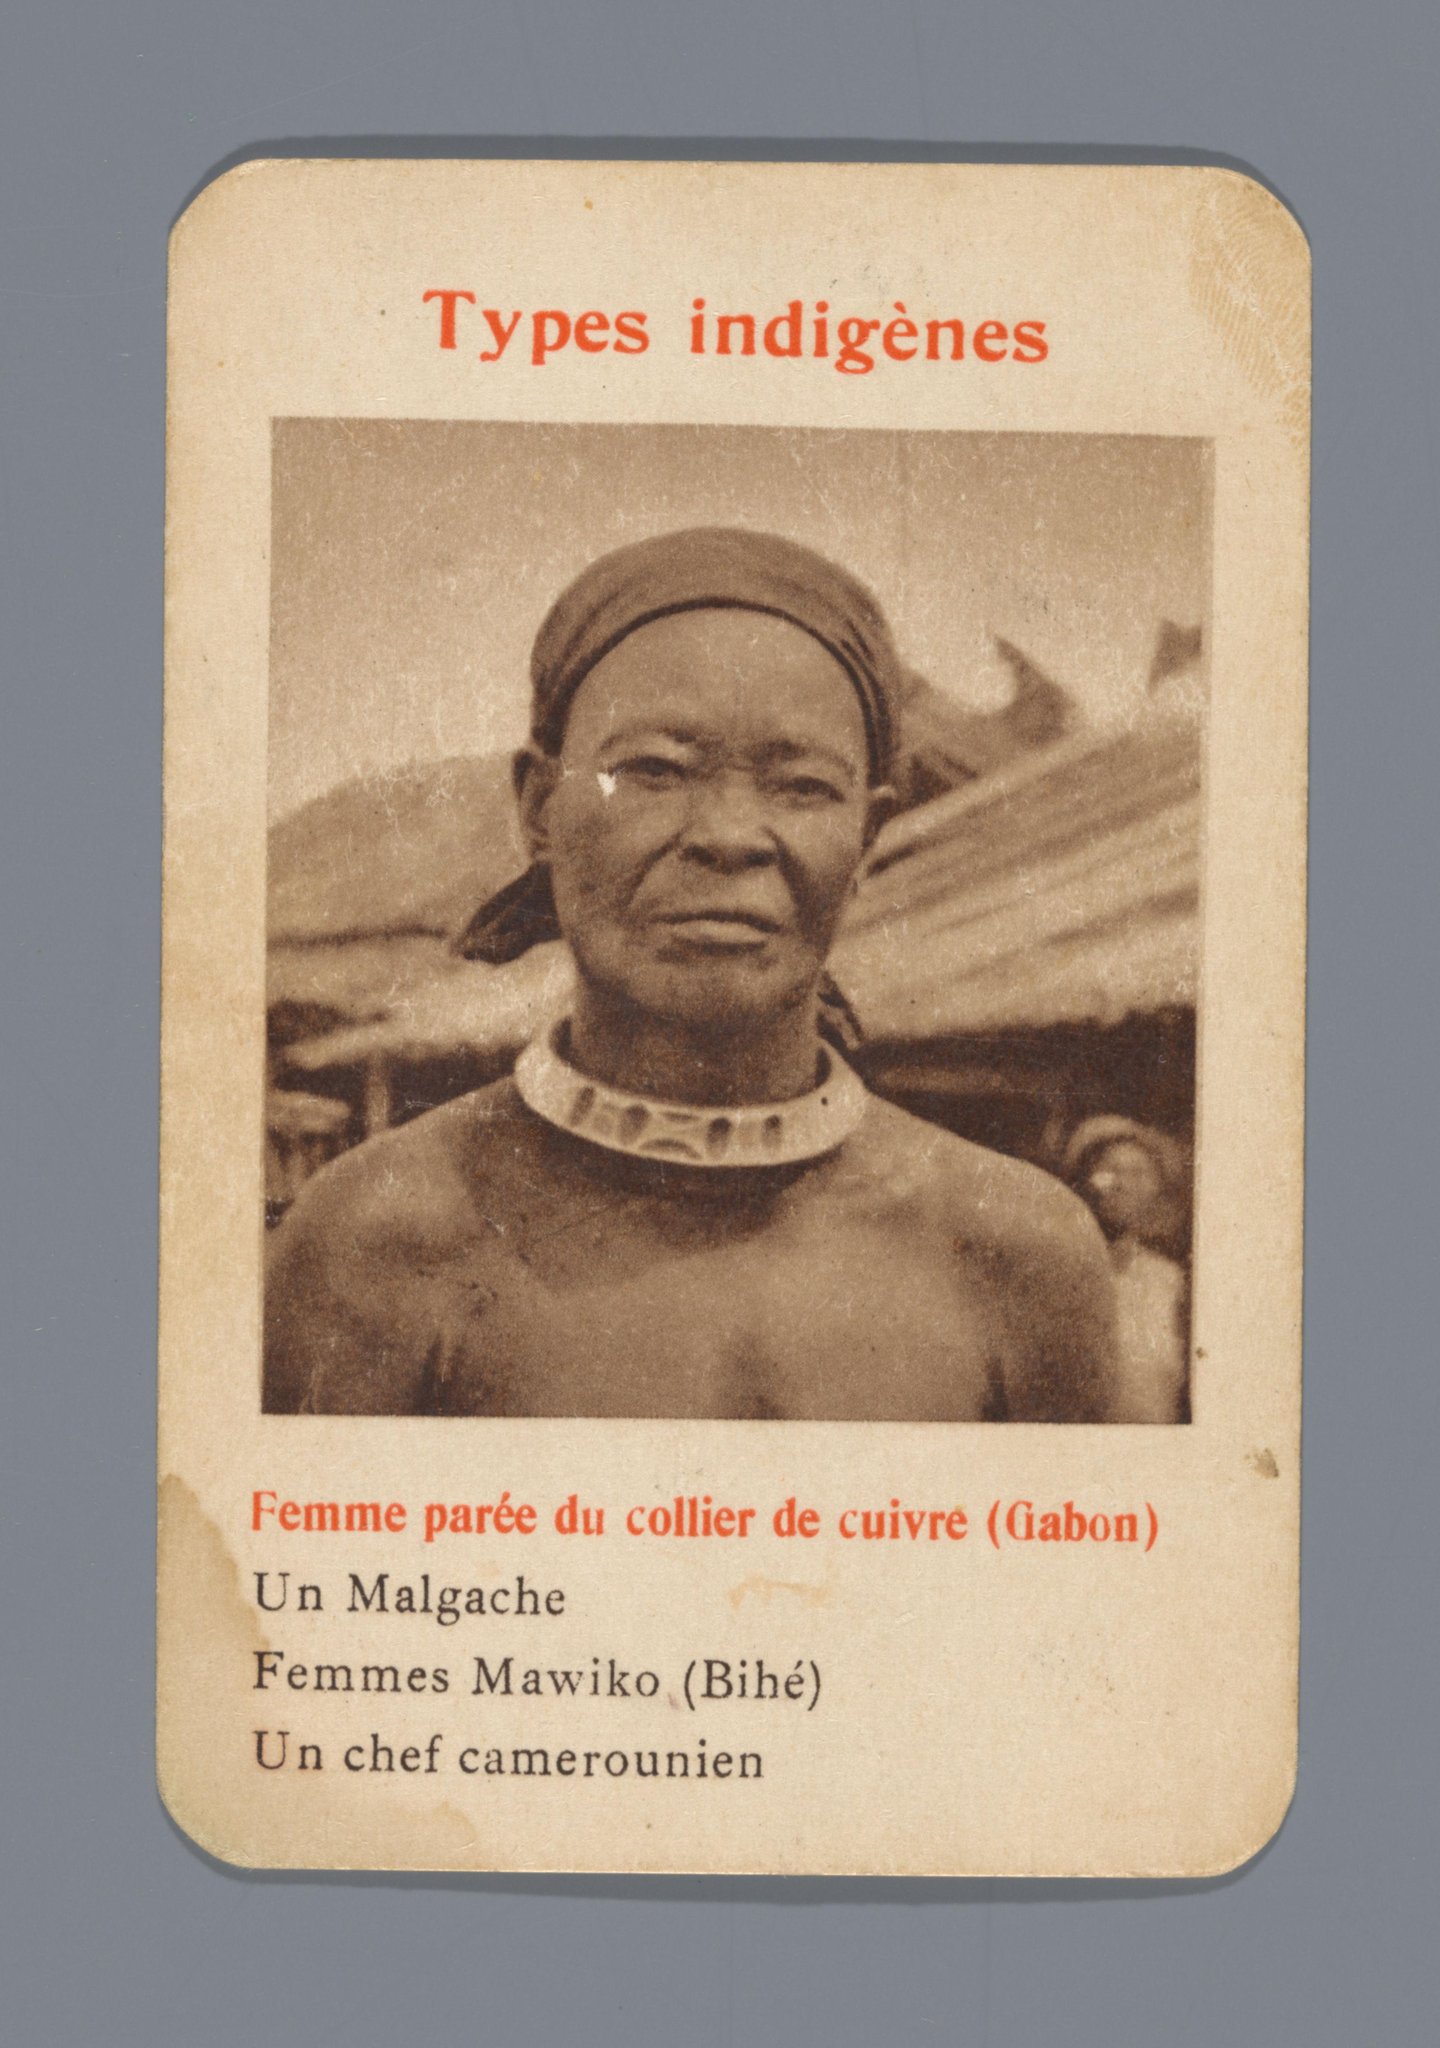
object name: card game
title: Femme parée du collier de cuivre (Gabon)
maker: Anonymous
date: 1900-1920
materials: cardboard, paper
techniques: rotogravure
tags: historical persons - bb - woman, africans, card games